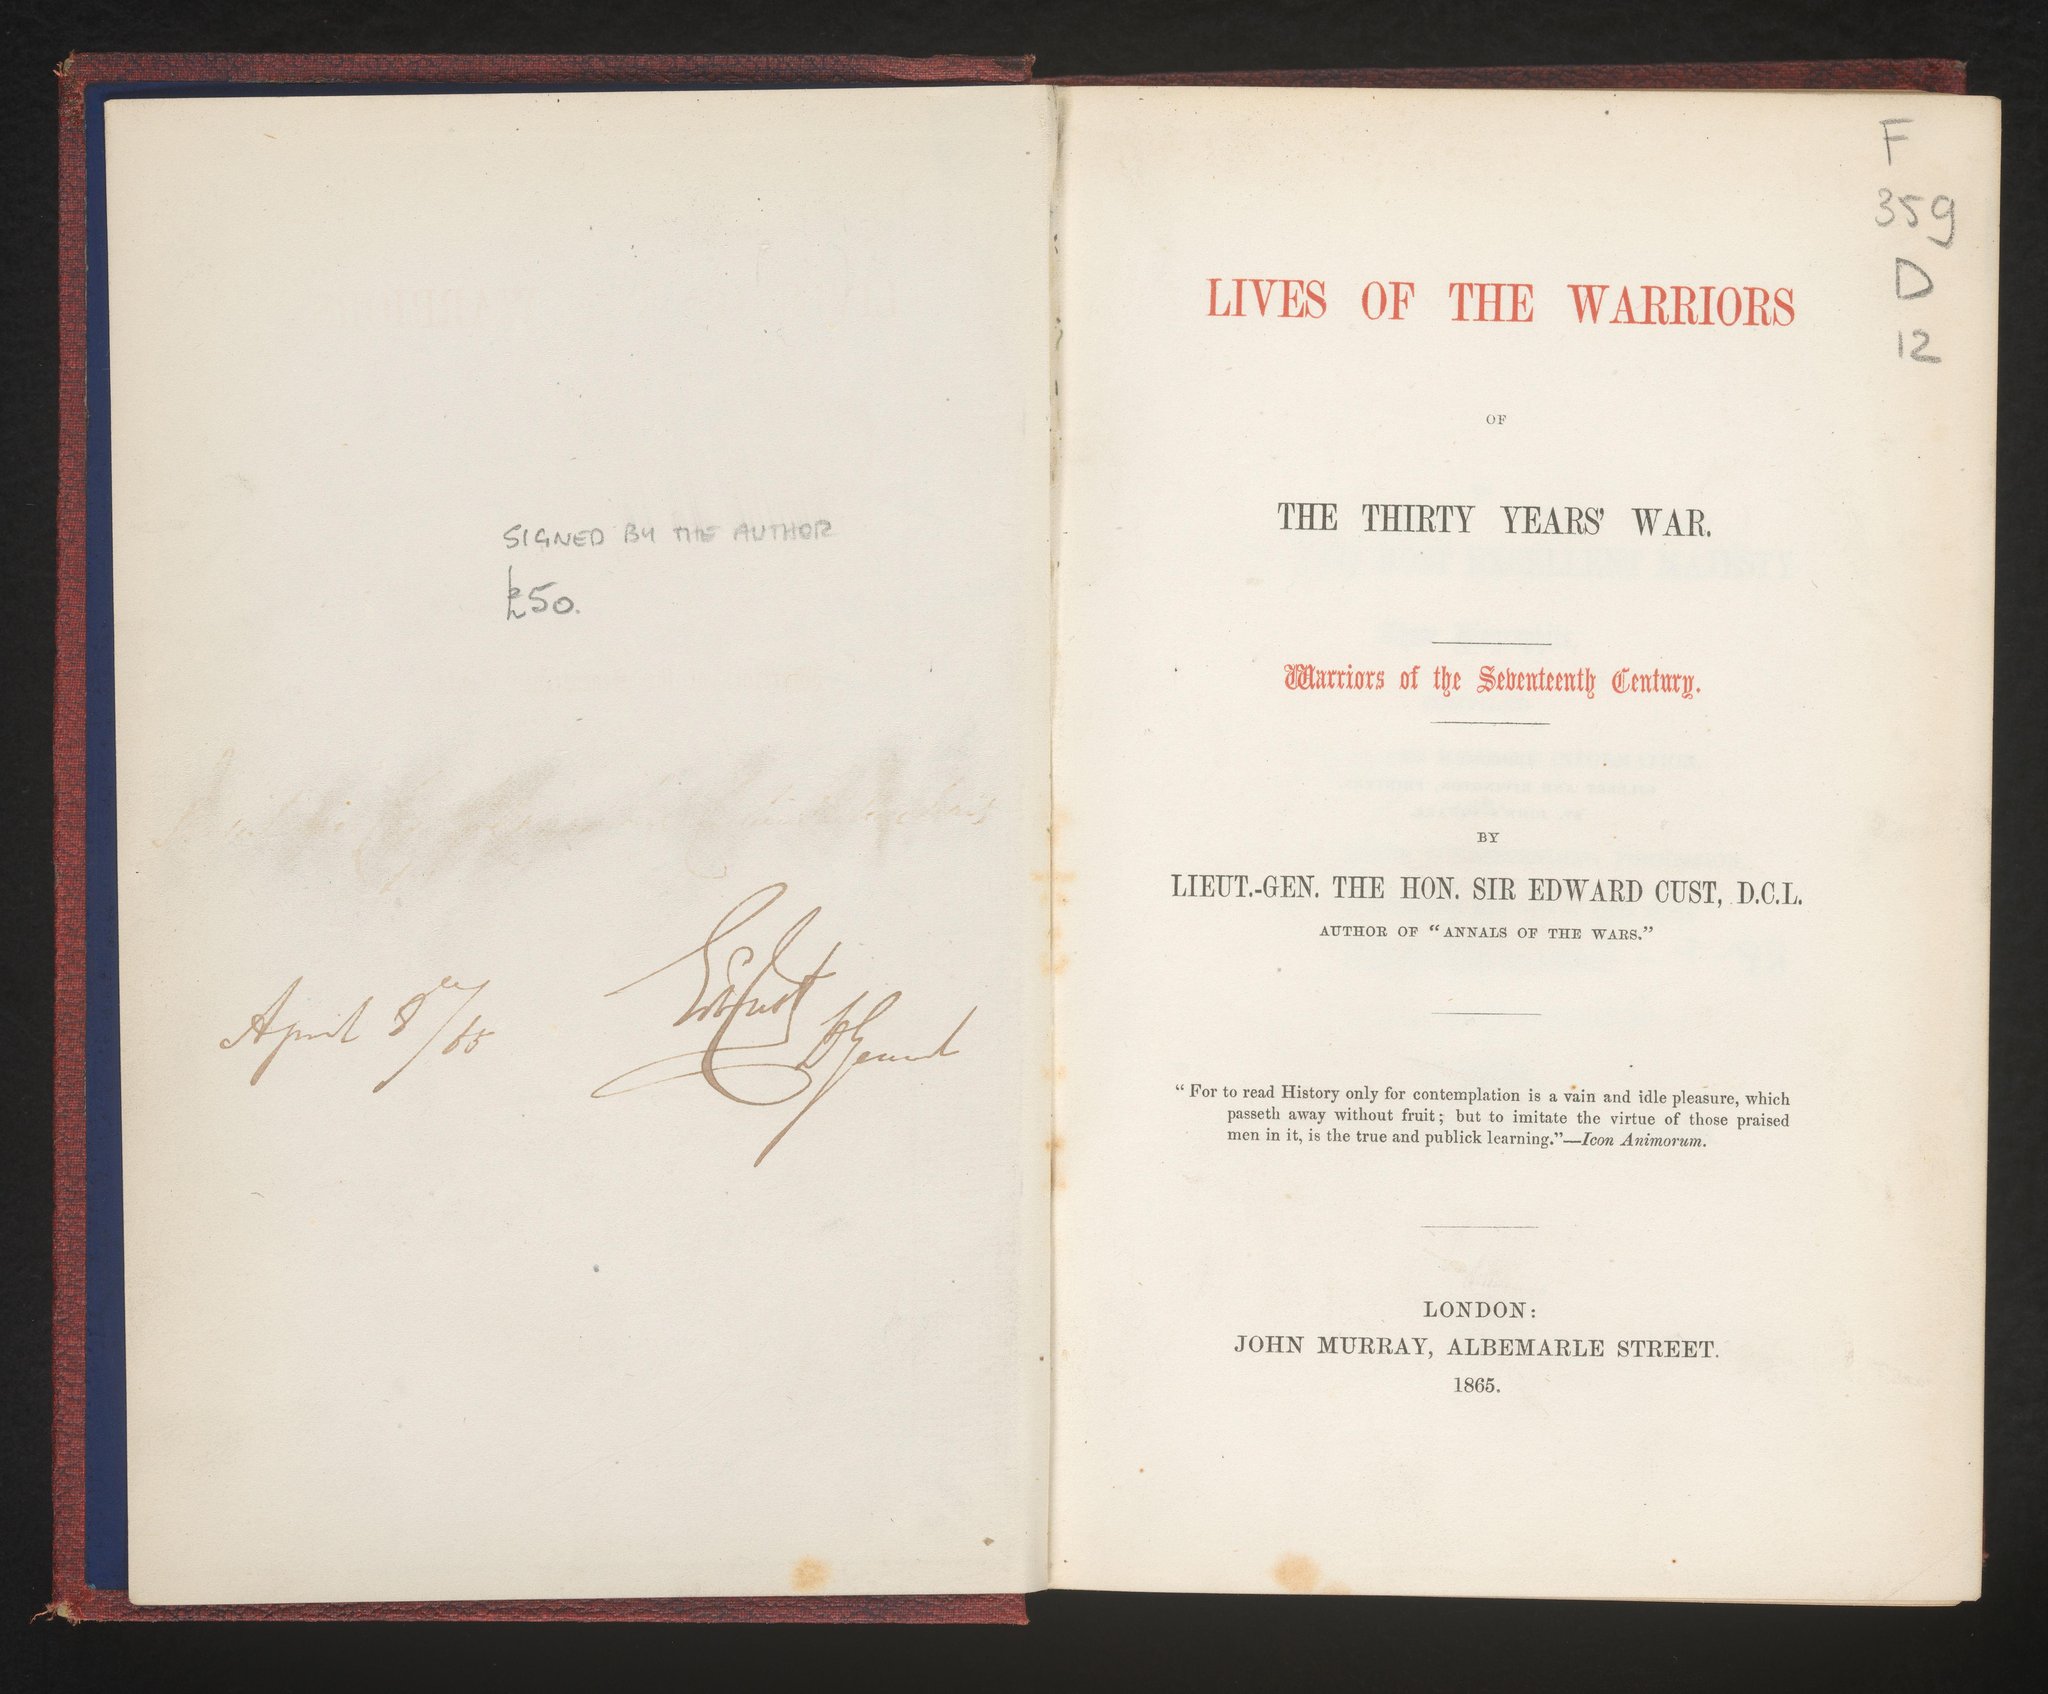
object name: book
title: Lives of the warriors of the Thirty Years' War : warriors of the seventeenth century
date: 1865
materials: linen, paper, photographic support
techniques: albumen print, printing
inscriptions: date: ‘Apr 1999’, annotation: ‘Signed by the author/ £50/ April 8/65/ [...]’, company name: ‘Bound by Westleys & co. London’